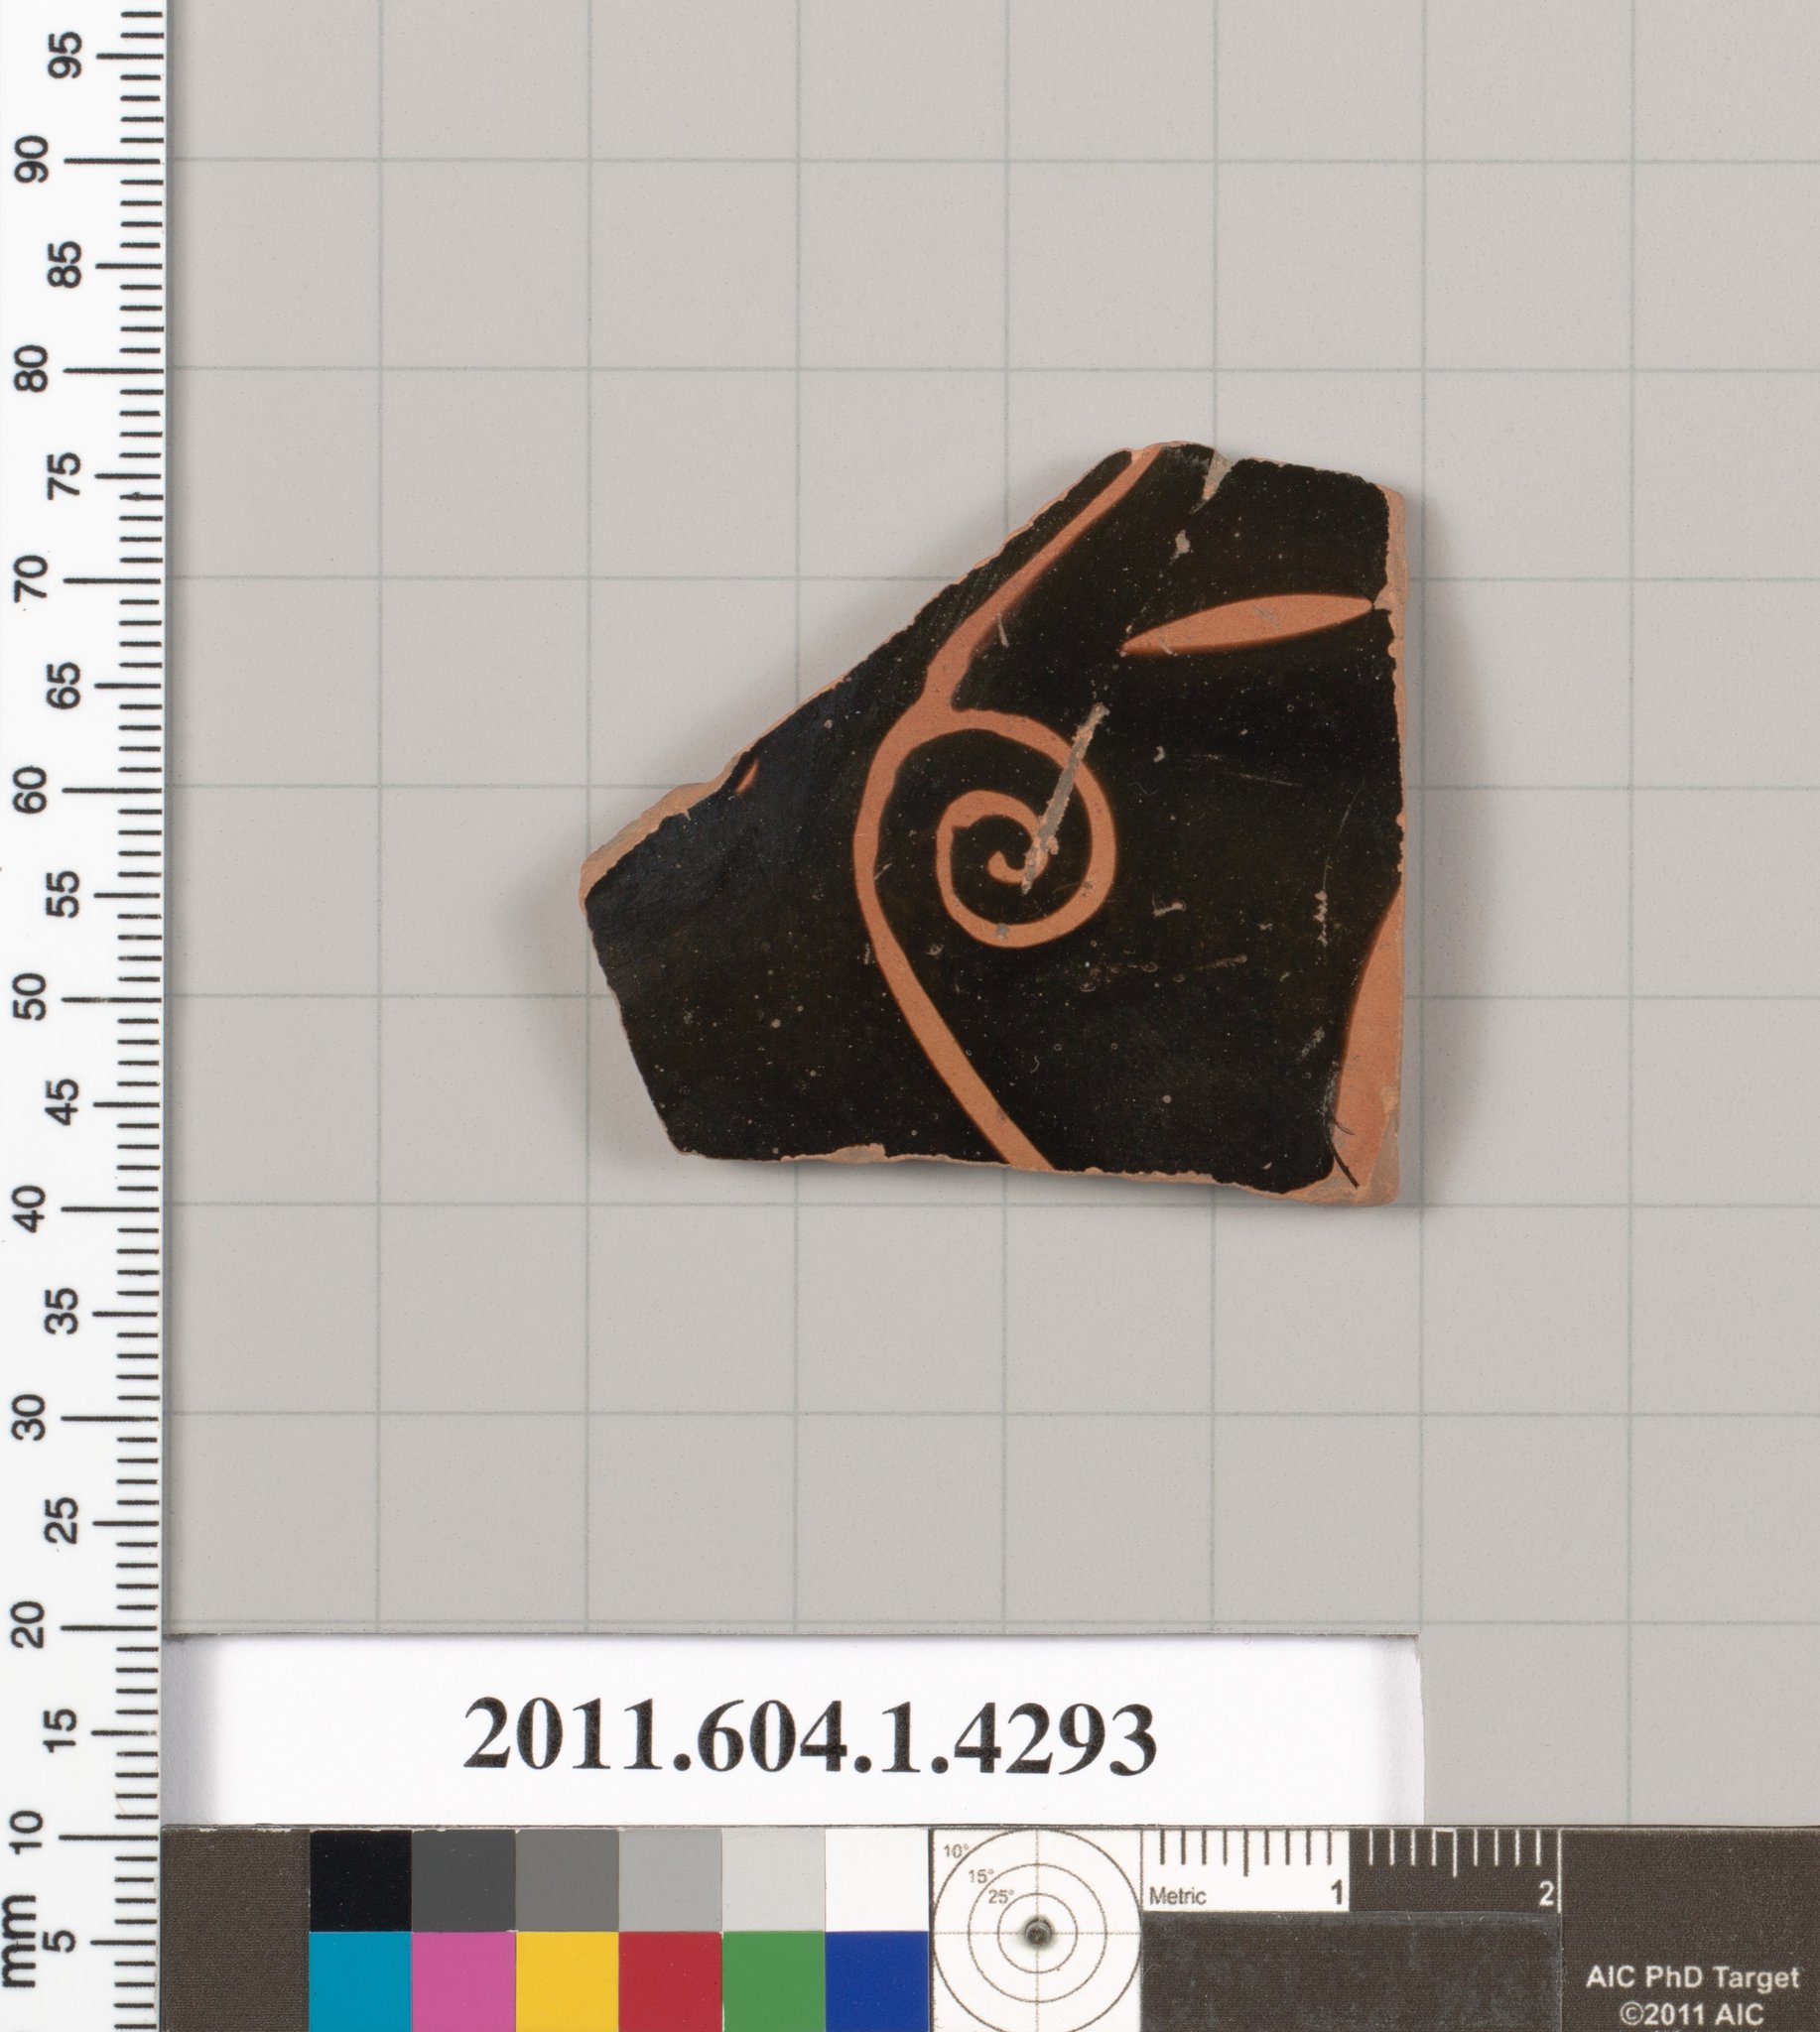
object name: kylix fragment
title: Terracotta fragment of a kylix (drinking cup)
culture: greek, attic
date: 475-451 BCE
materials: terracotta